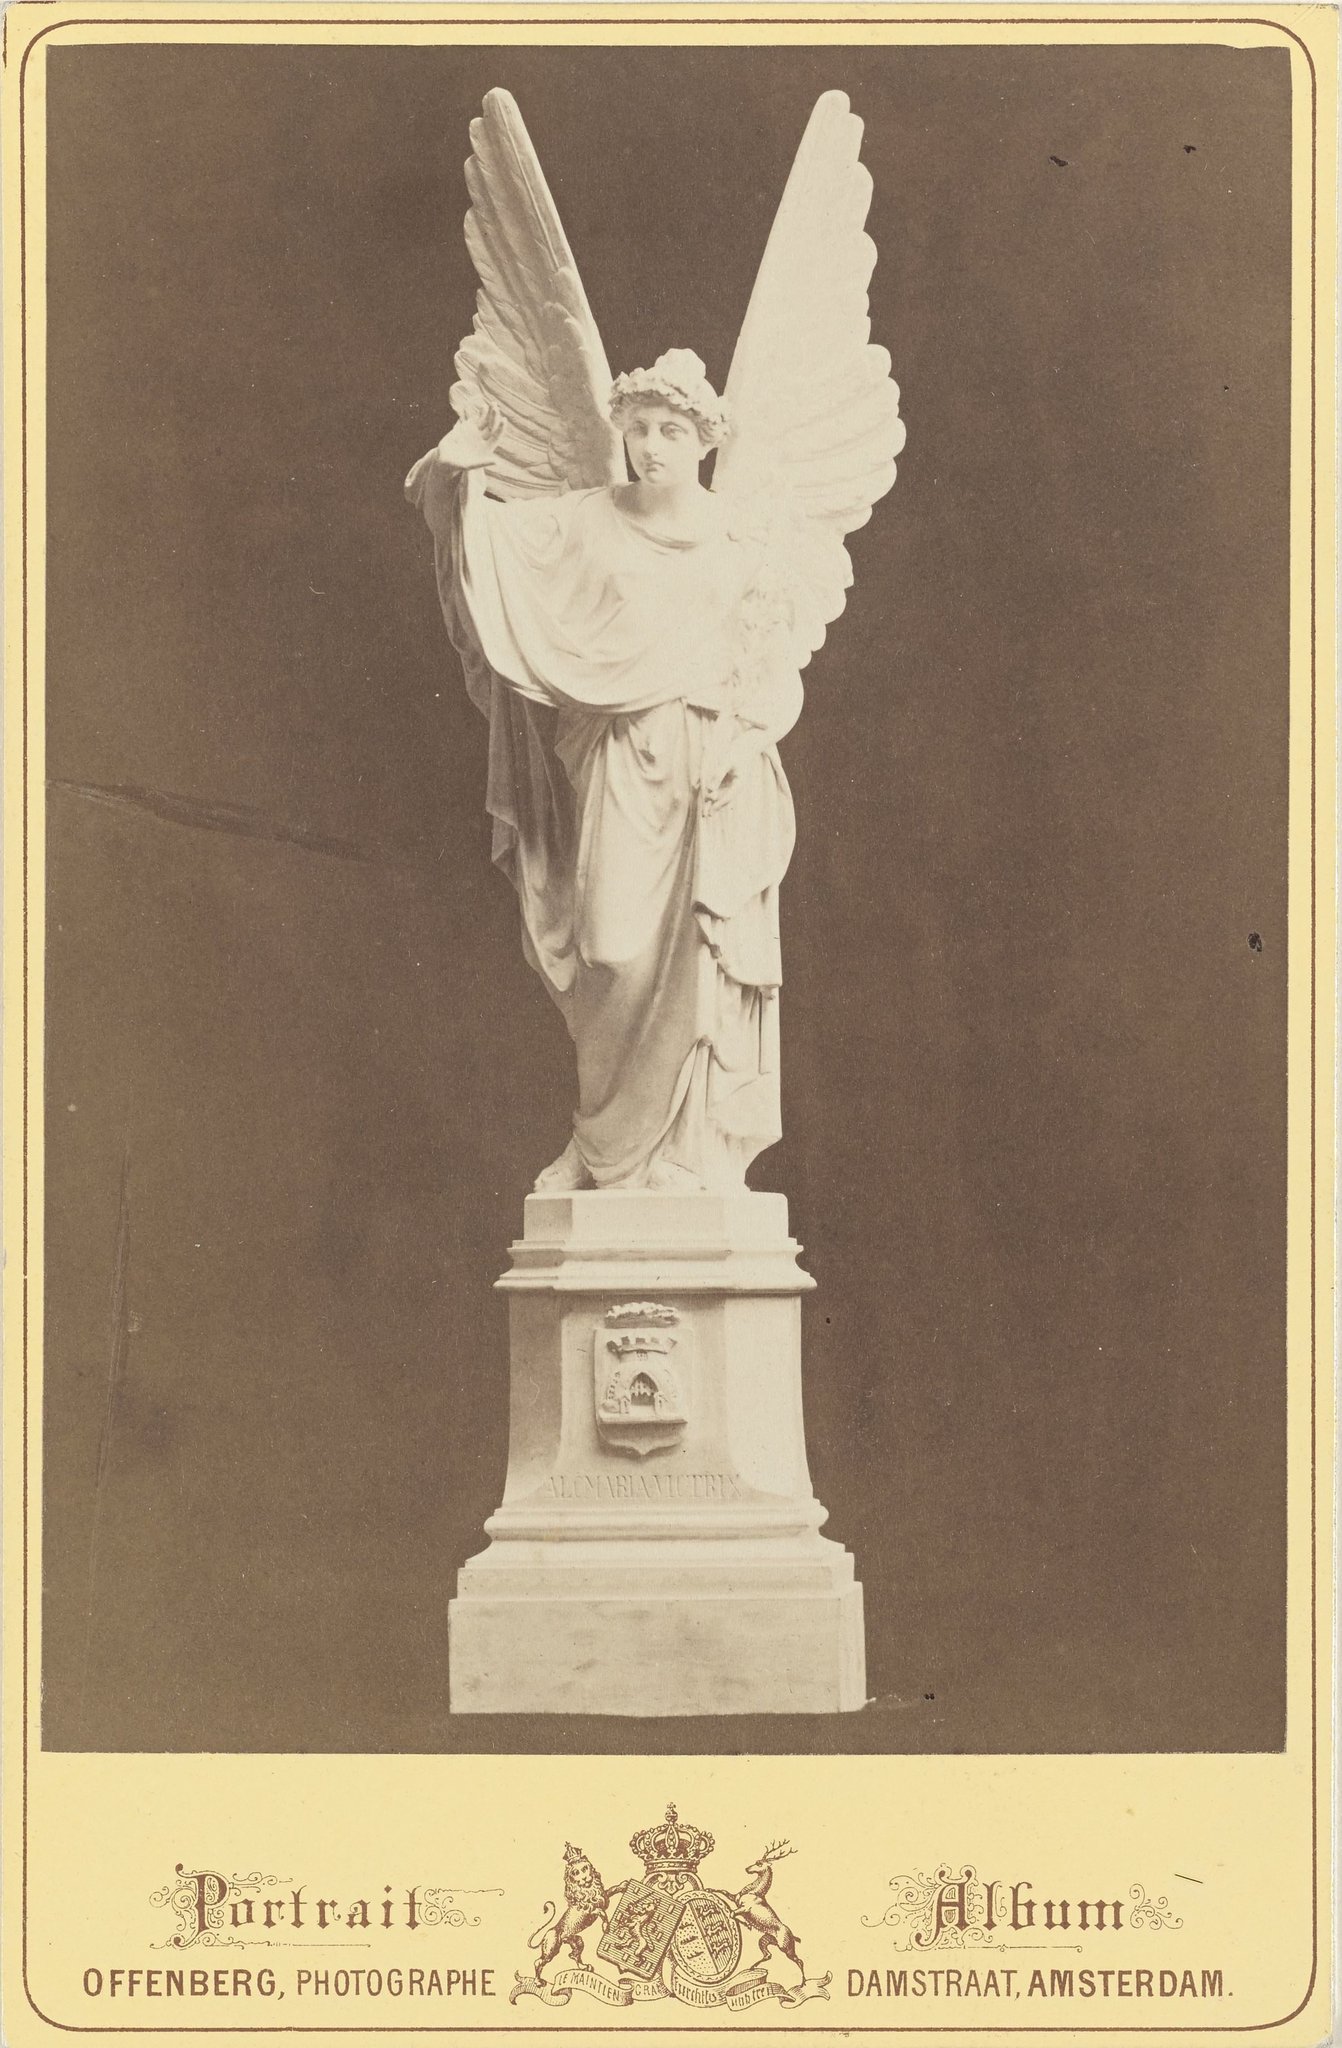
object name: photograph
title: Alcmaria Victrix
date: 1873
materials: cardboard, paper, photographic support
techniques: albumen print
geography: netherlands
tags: piece of sculpture, reproduction of a piece of sculpture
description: Model voor het monument Alcmaria Victrix. De eerste steen voor dit monument is door koning Willem III gelegd op 9 oktober 1873 tijdens het derde eeuwfeest van het beleg en verlossing van Alkmaar. Standbeeld van Victoria, godin van de overwinning, staande op een voetstuk met het stadswapen van Alkmaar. Het monument is onthuld op 9 oktober 1876 in het Victoriepark te Alkmaar. Bij de foto behoort een tekstblad, beide zijn verspreid met het doel om geld in te zamelen voor het monument.